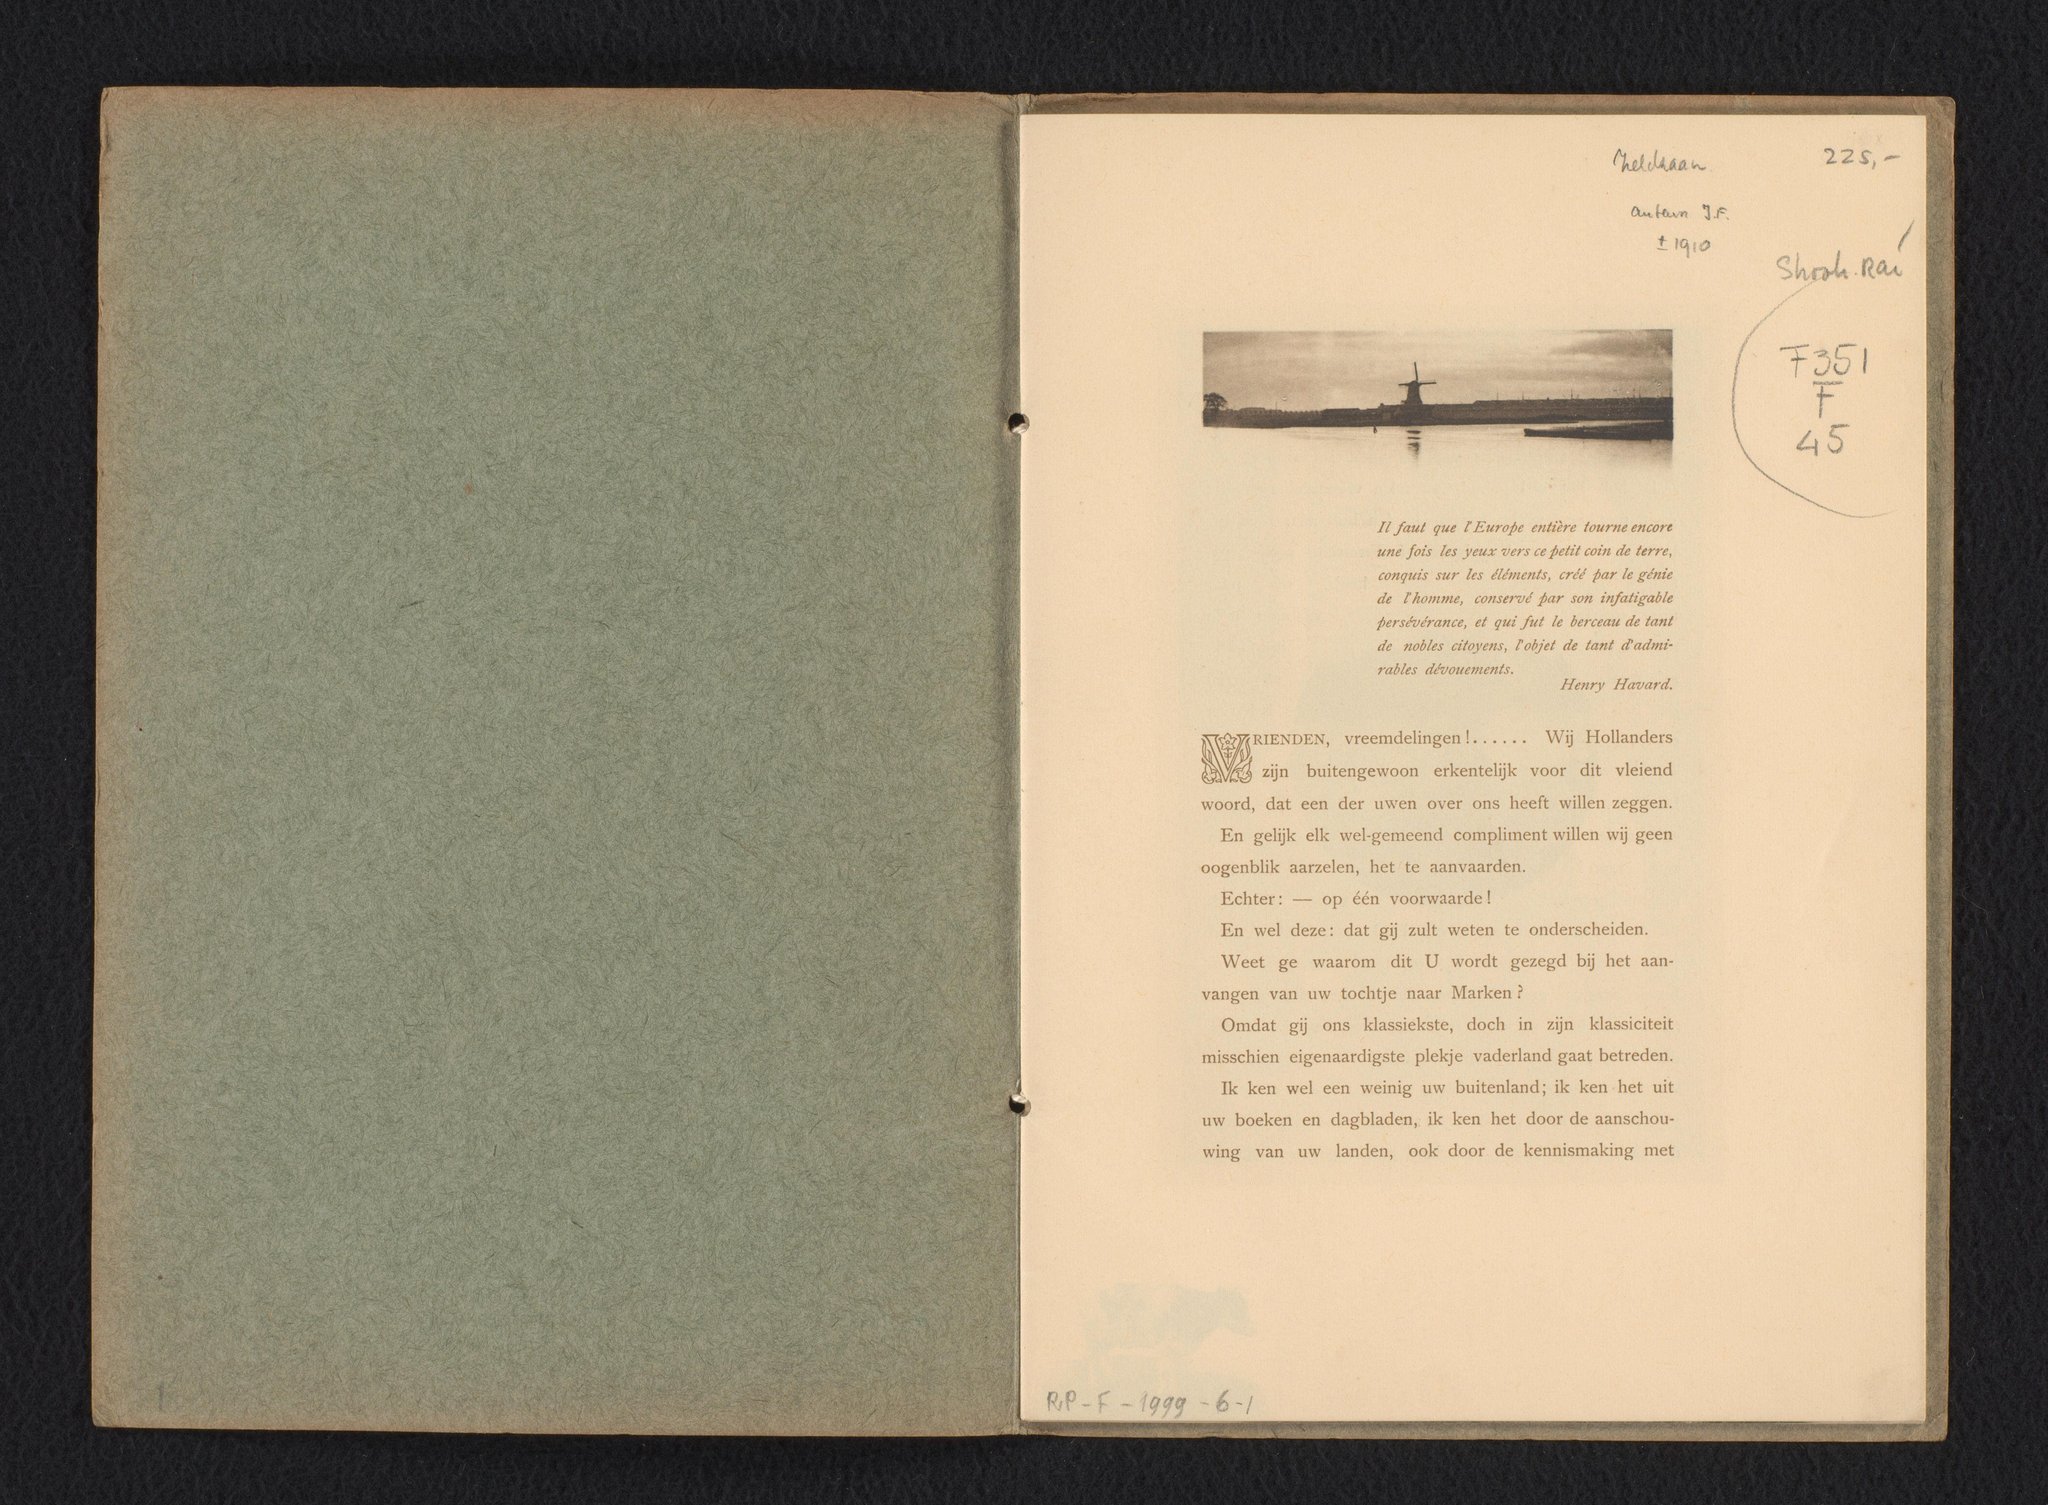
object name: page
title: Molen aan het water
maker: Anonymous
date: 1905-1910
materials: paper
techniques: photograph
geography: north holland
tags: windmill in landscape